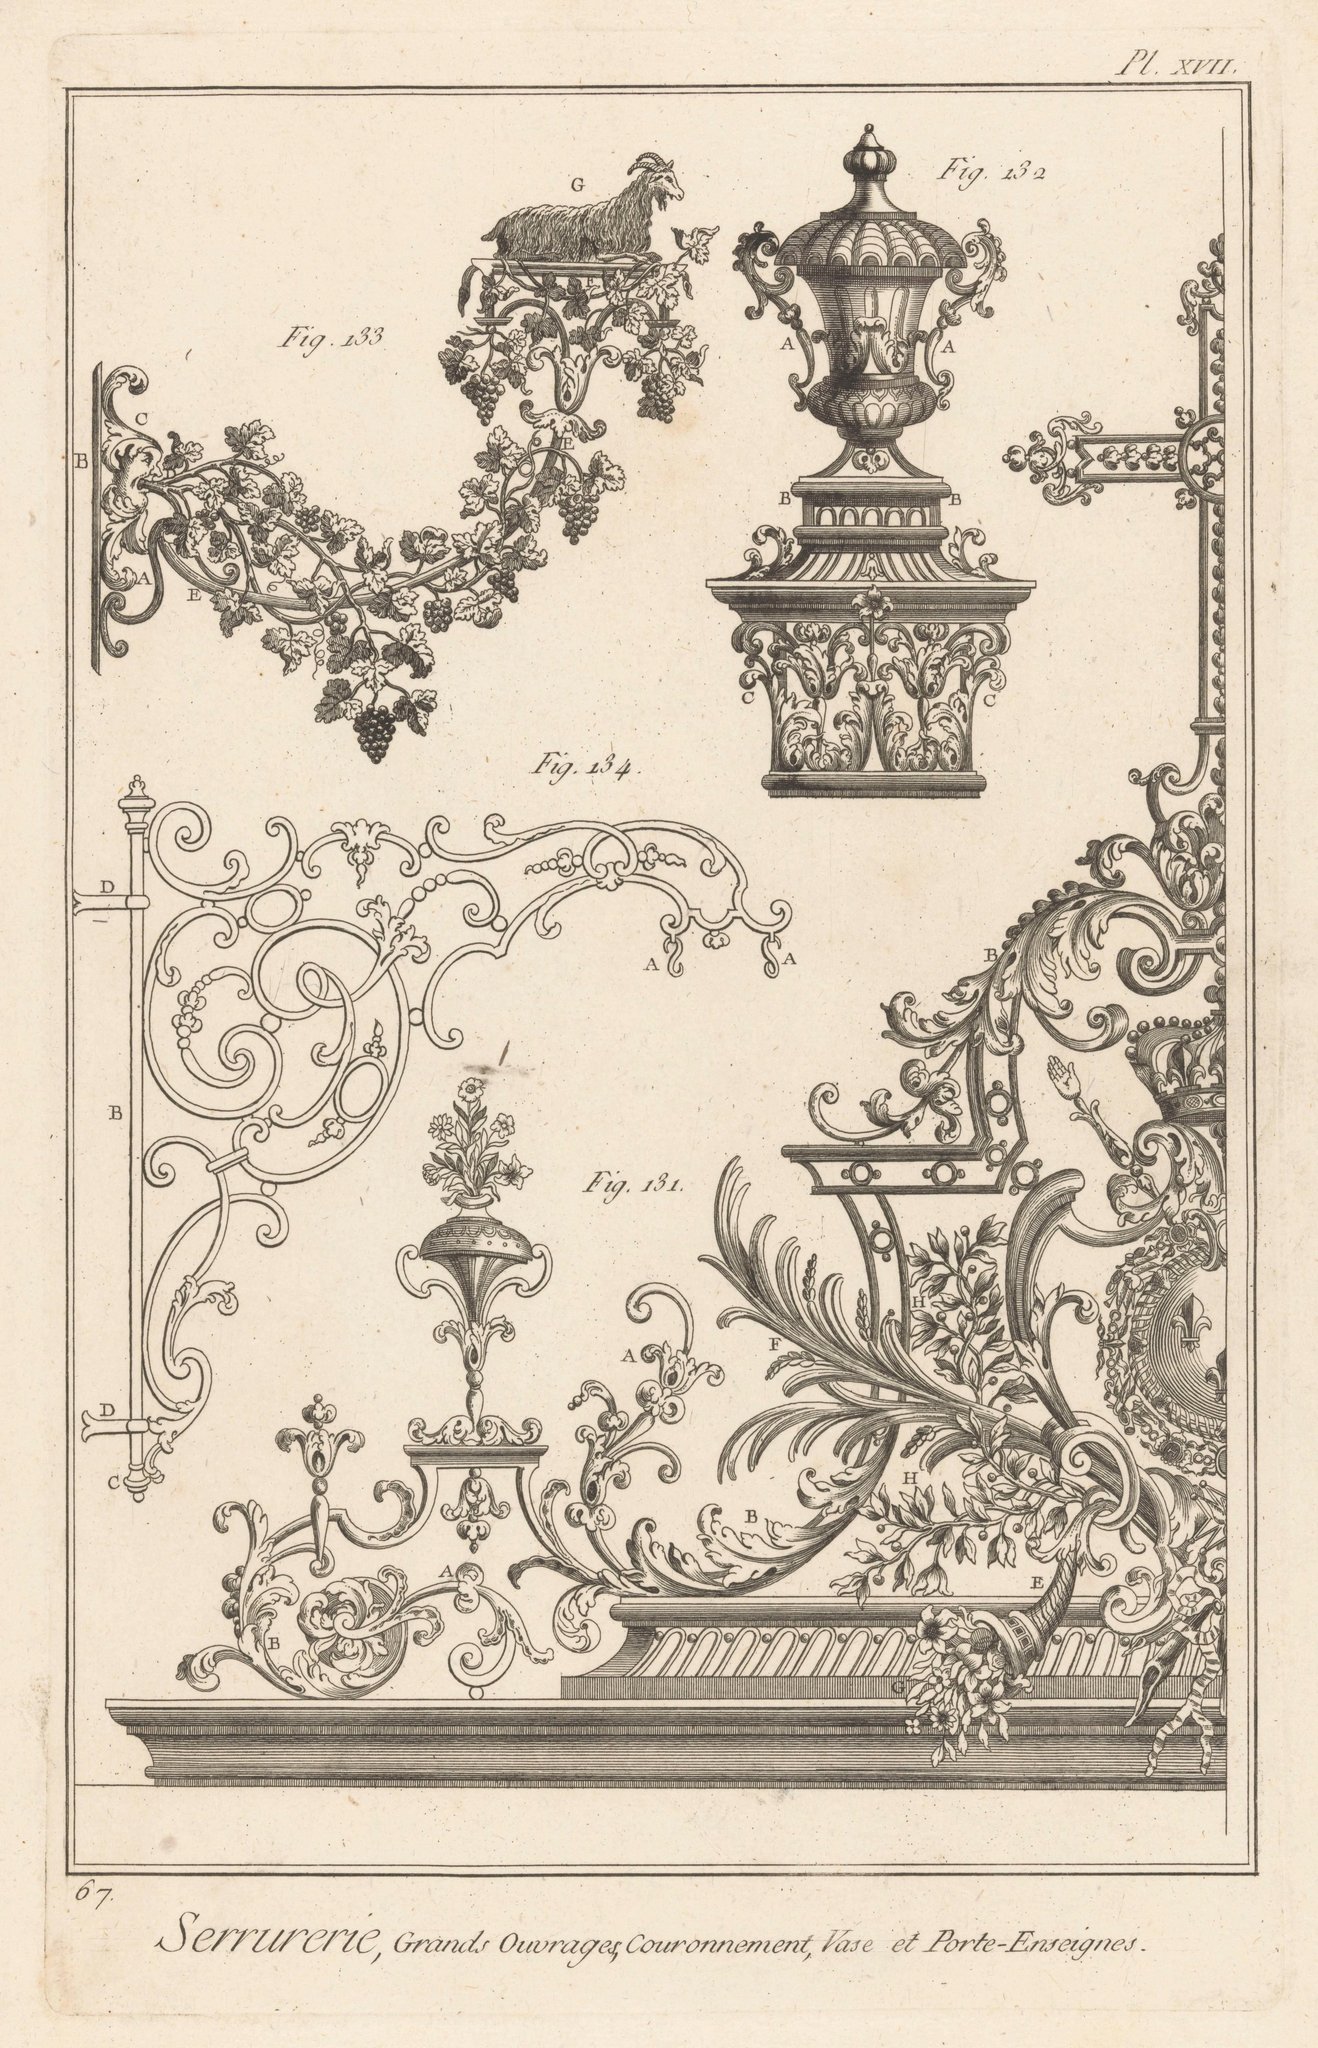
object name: print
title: Serrurerie, Grands Ouvrages, Couronnement, Vase et Porte-Enseignes.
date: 1770-1780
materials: paper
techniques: engraving, etching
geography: yverdon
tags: lock-smith, fence, wall, paling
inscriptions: collector's mark: Lugt 2228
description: Prent uit: Diderot, Denis en d'Alembert, Jean Baptiste le Rond. Encyclopédie ou dictionnaire universel raisonné des connoissances humaines. Yverdon: Felice, Fortunatio Bartolomeo de, 1770-1780. Pagina 67.